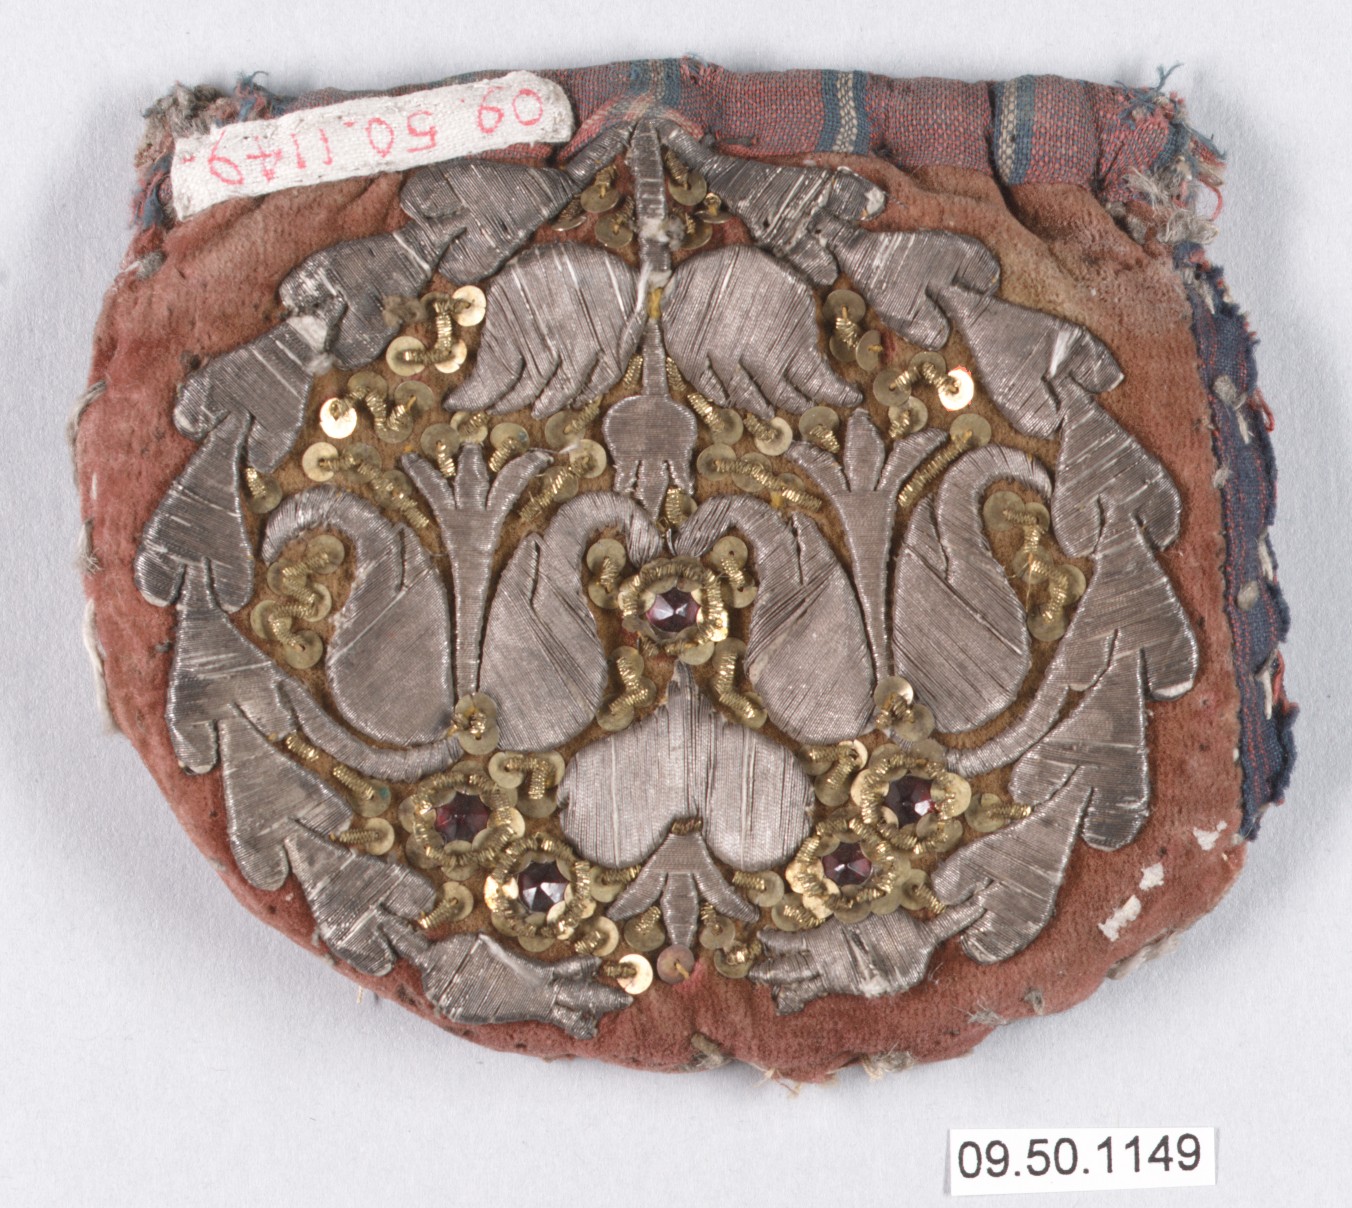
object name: cap crown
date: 1701-1800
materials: metal thread, velvet